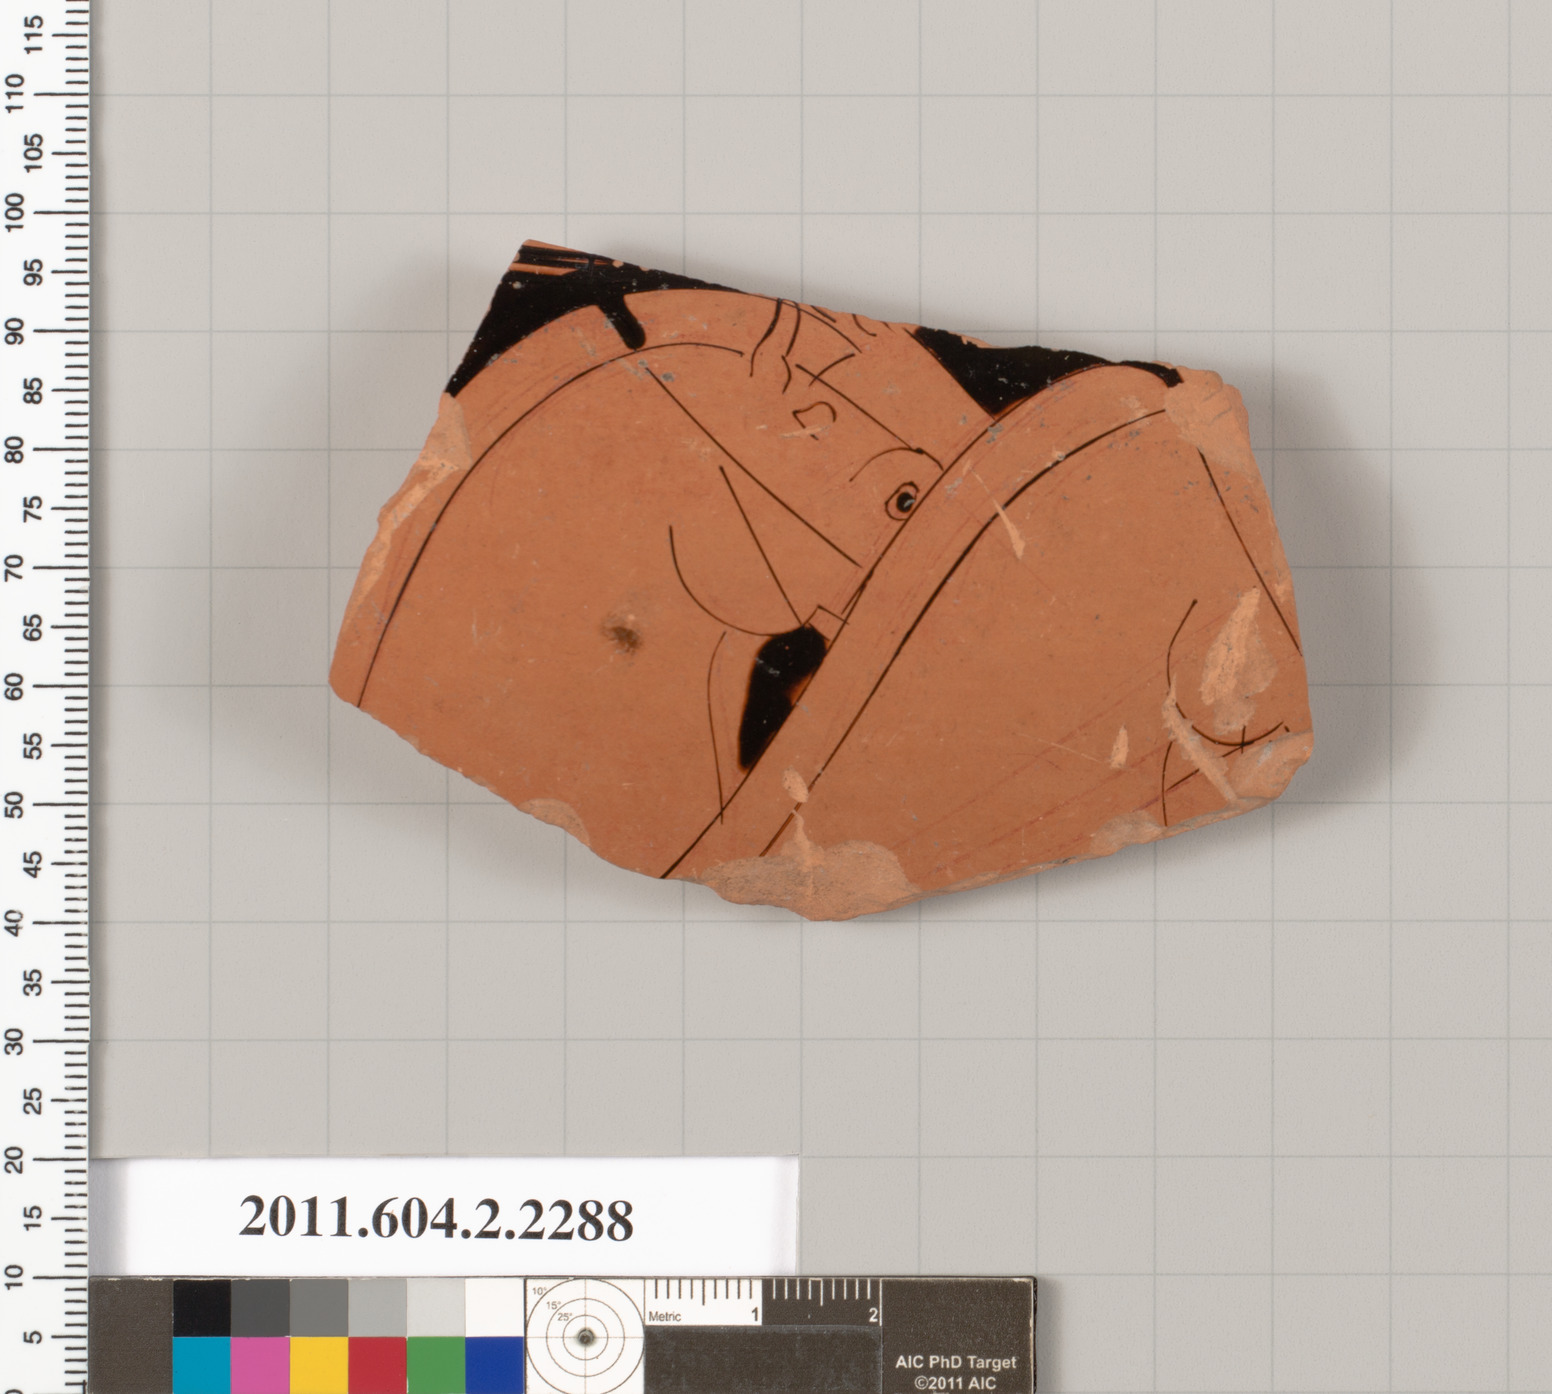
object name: column krater fragment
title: Terracotta fragment of a column-krater (bowl for mixing wine and water)?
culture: greek, attic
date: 475-451 BCE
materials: terracotta